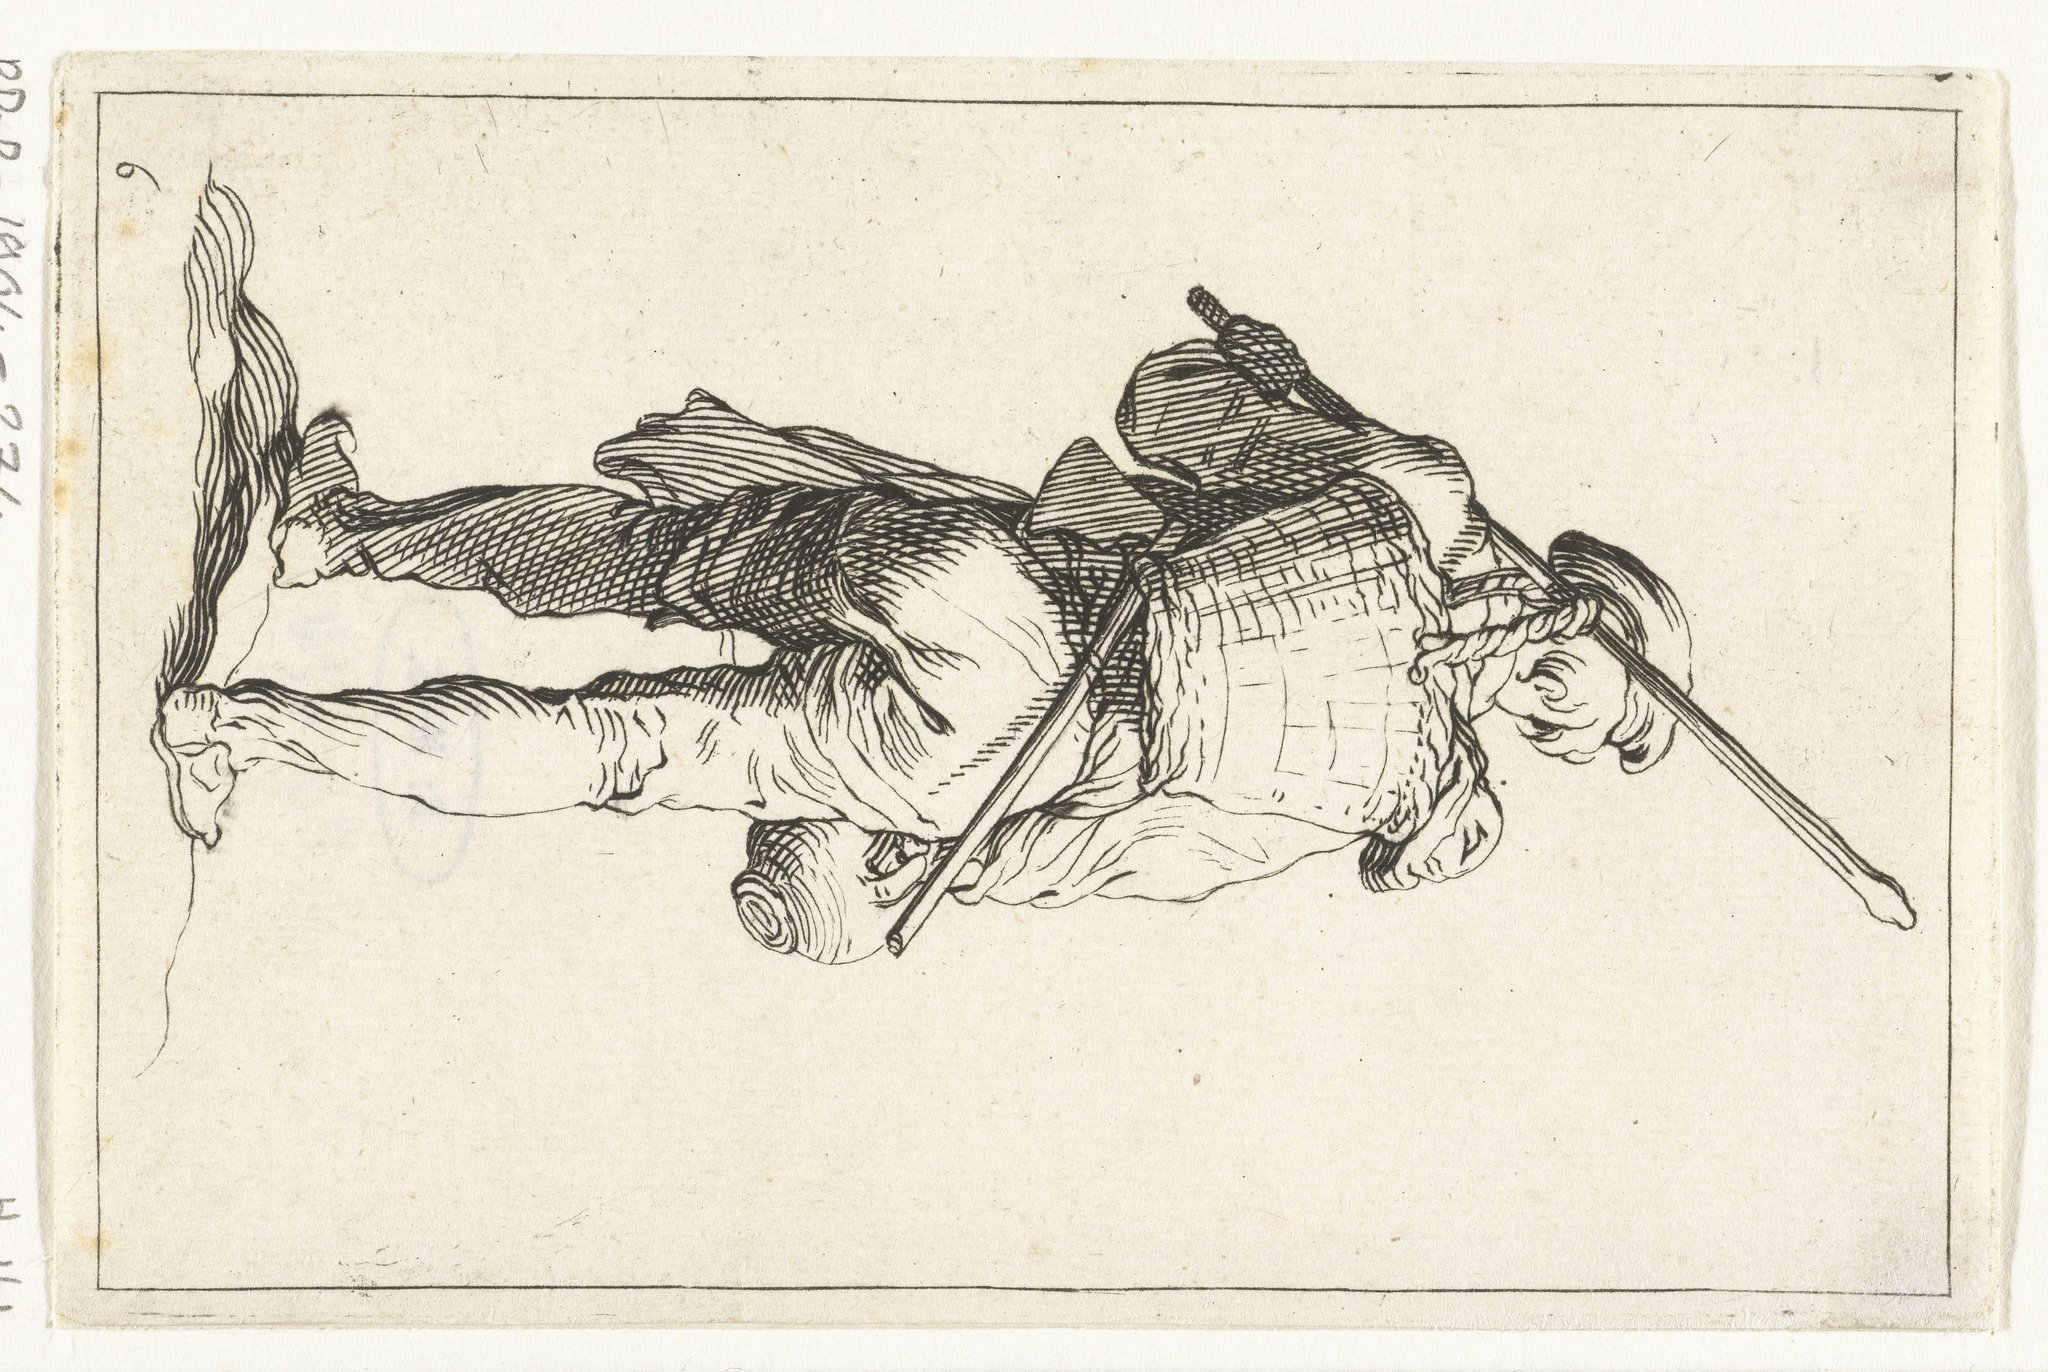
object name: print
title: De kleine figuren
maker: frederick bloemaert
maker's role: print maker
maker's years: 1614-1669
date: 1635-1669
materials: paper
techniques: engraving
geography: utrecht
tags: the ages of man (+ young male (human being))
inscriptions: collector's mark: Lugt 2228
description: Man, op zijn rug gezien, waarover, aan een stok, een mand hangt.